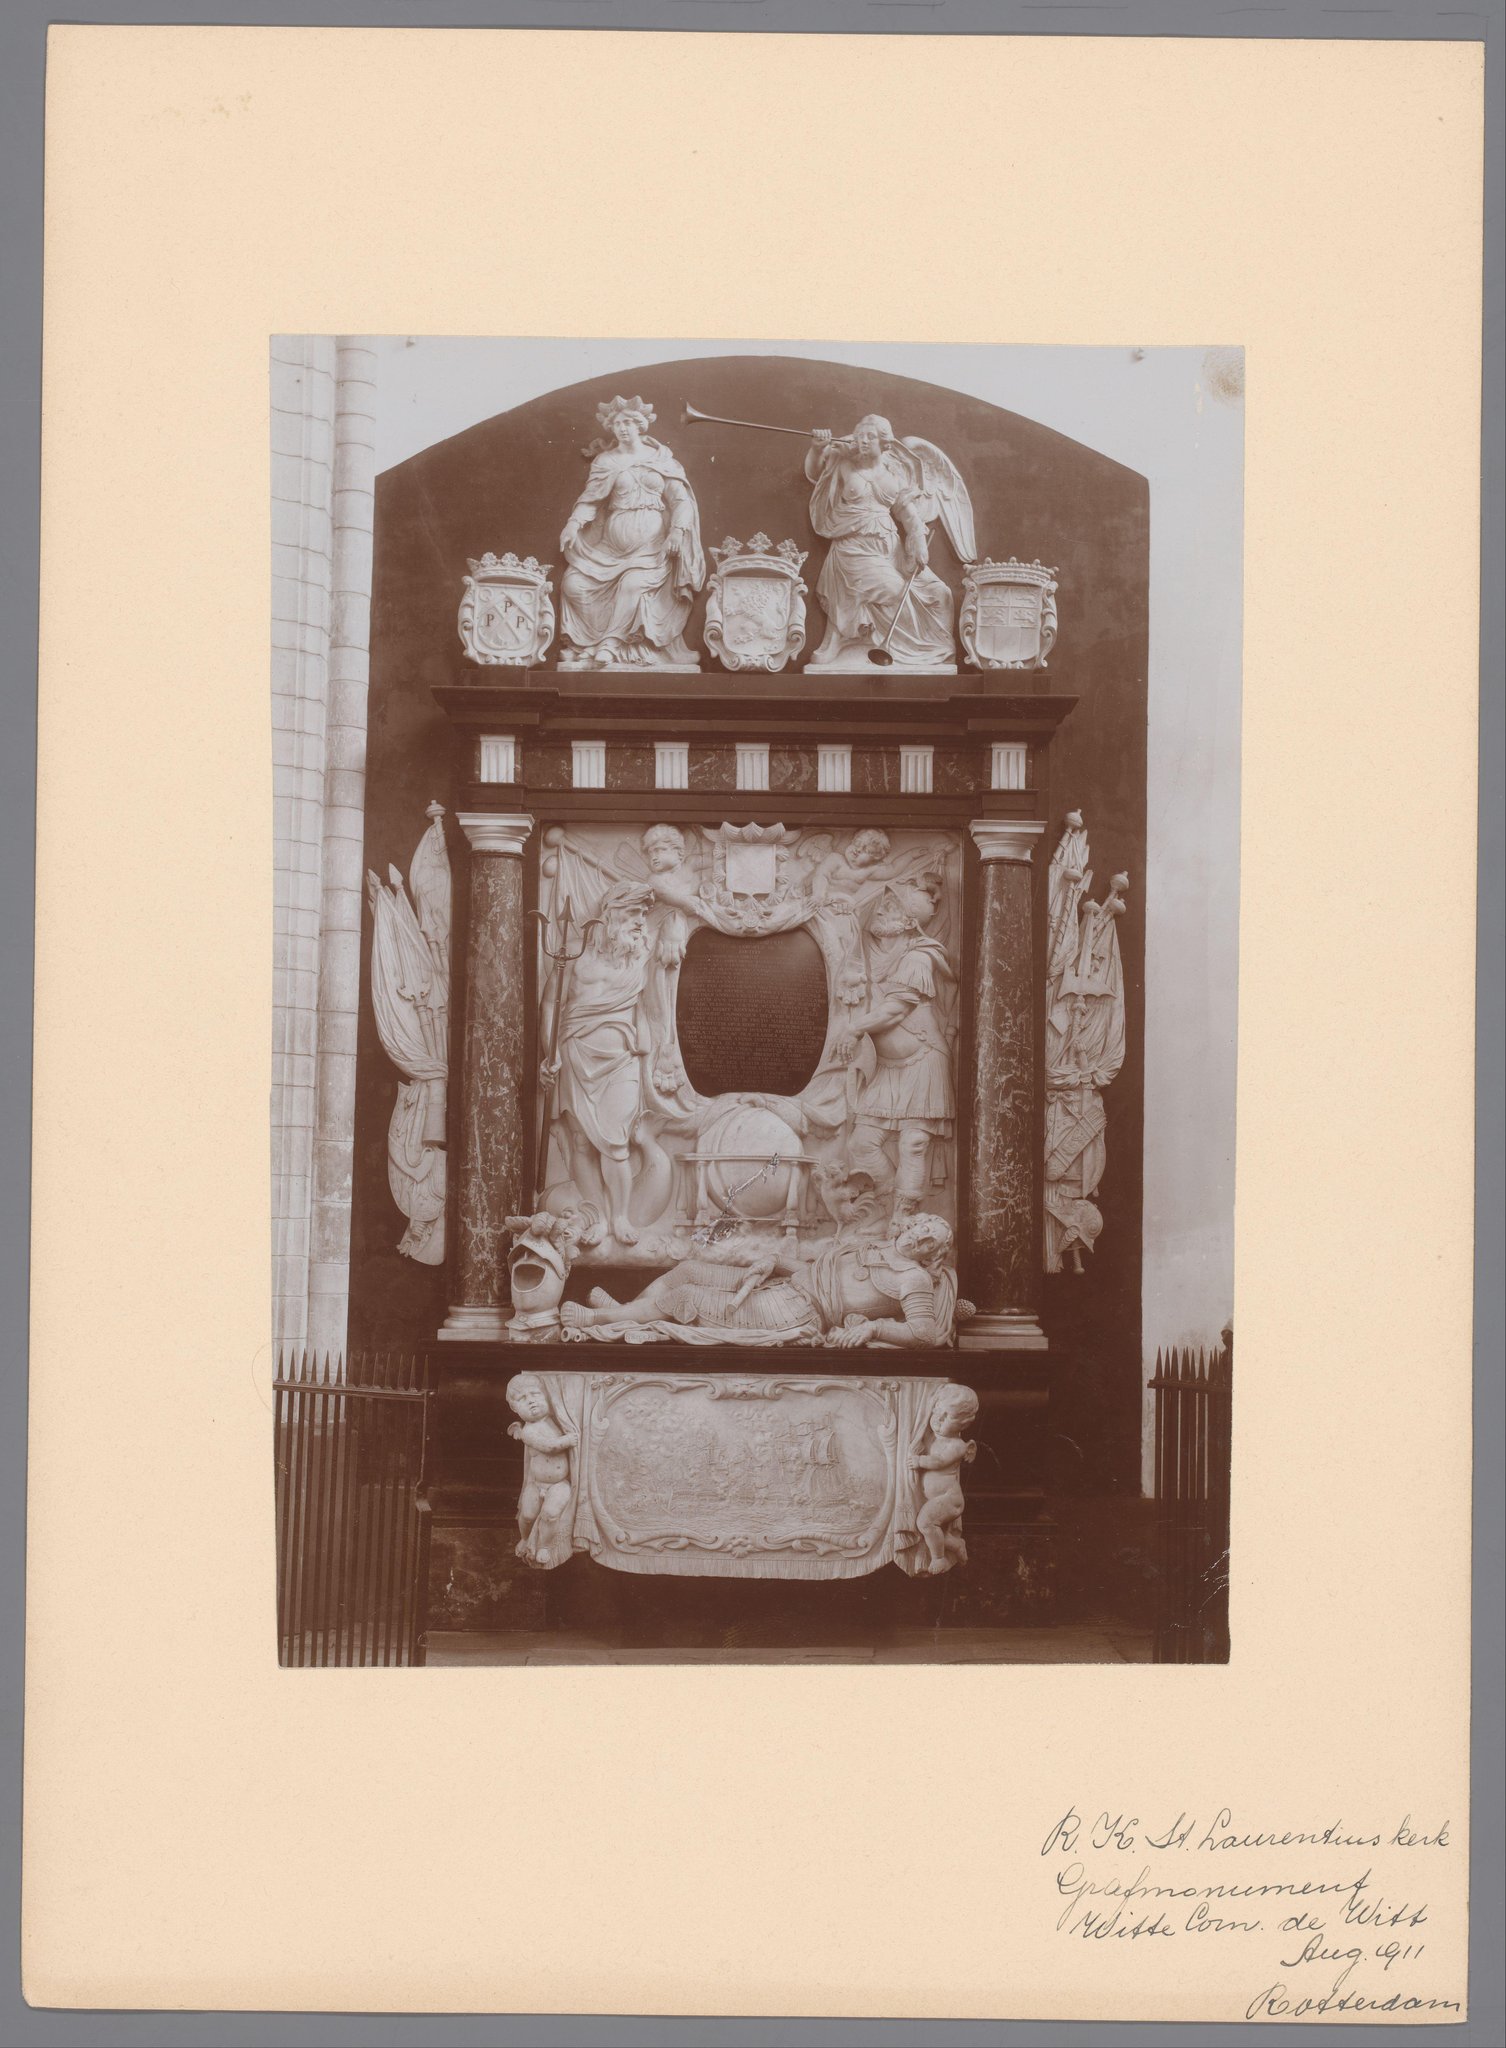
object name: photograph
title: Grafmonument van Cornelis de Witt in de Grote of Sint-Laurenskerk te Rotterdam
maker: anoniem (monumentenzorg)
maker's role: fotograaf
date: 1911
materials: cardboard, photographic support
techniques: collodion silver print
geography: grote of sint-laurenskerk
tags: dordrecht, the hague, cornelis de witt, interior of church, grave-building, monumental tomb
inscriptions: annotation: ‘R.K. St. Laurentius kerk/ Grafmonument Witte Corn. de Witt/ Aug. 1911/ Rotterdam’, collector's mark: ‘R.MUS.’, annotation: ‘Lodewijk XIV/ 1640-1715’